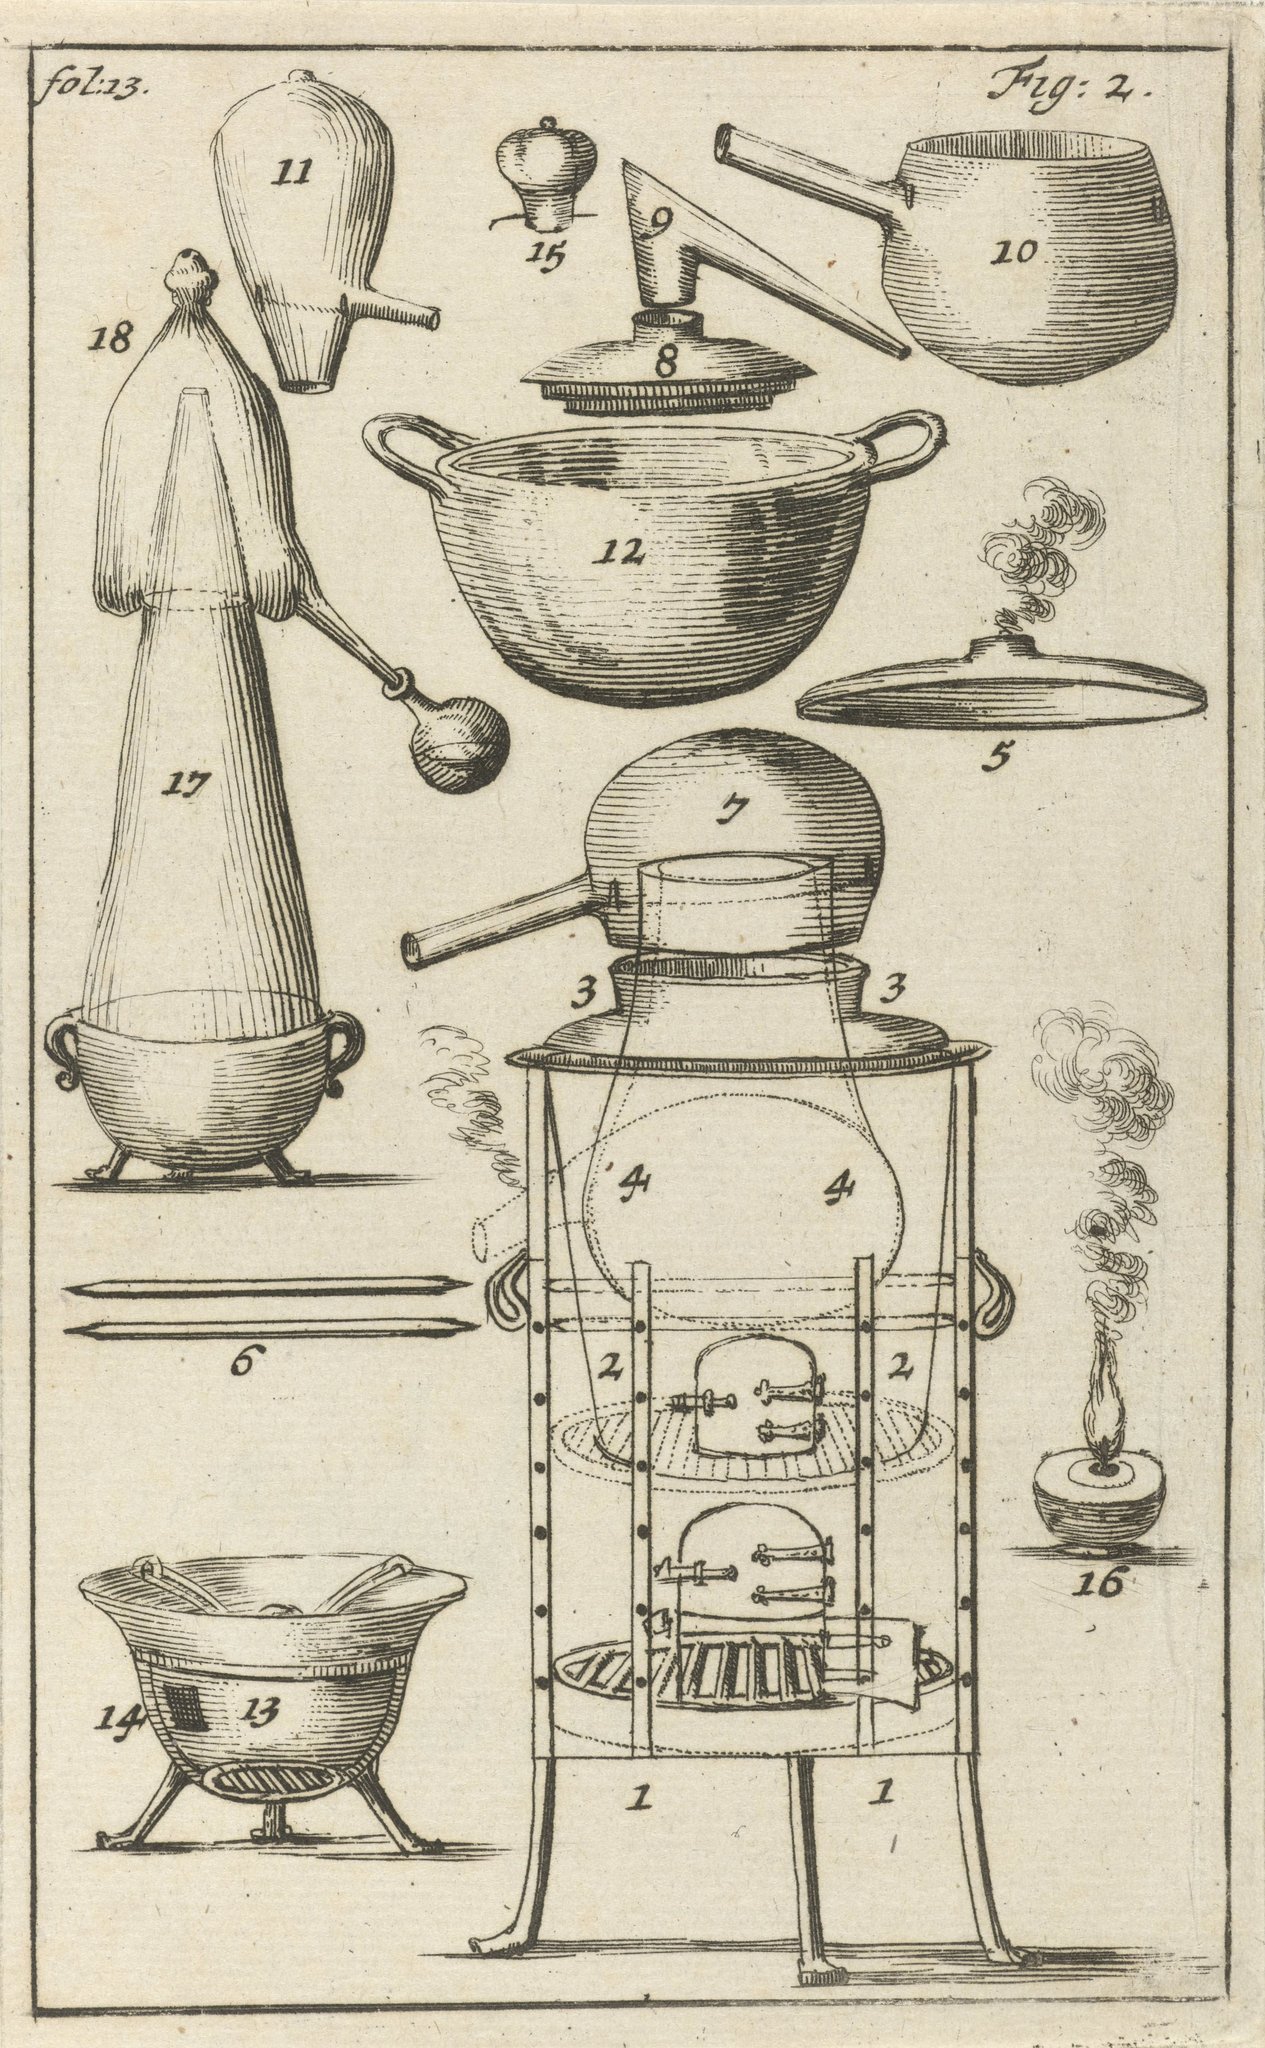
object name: print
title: Verschillende distilleertoestellen met aanduidingen 1-17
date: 1689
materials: paper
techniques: etching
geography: amsterdam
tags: laboratory (+ tools, instruments; laboratory equipment ~ scientific research), pharmacy, pharmaceutics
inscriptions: collector's mark: Lugt 2228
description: Illustratie uit: Halmaal, Jacob van. Ontleding over d'Amsterdamsche apotheek. Amsterdam: Jan Claesz ten Hoorn, 1689.